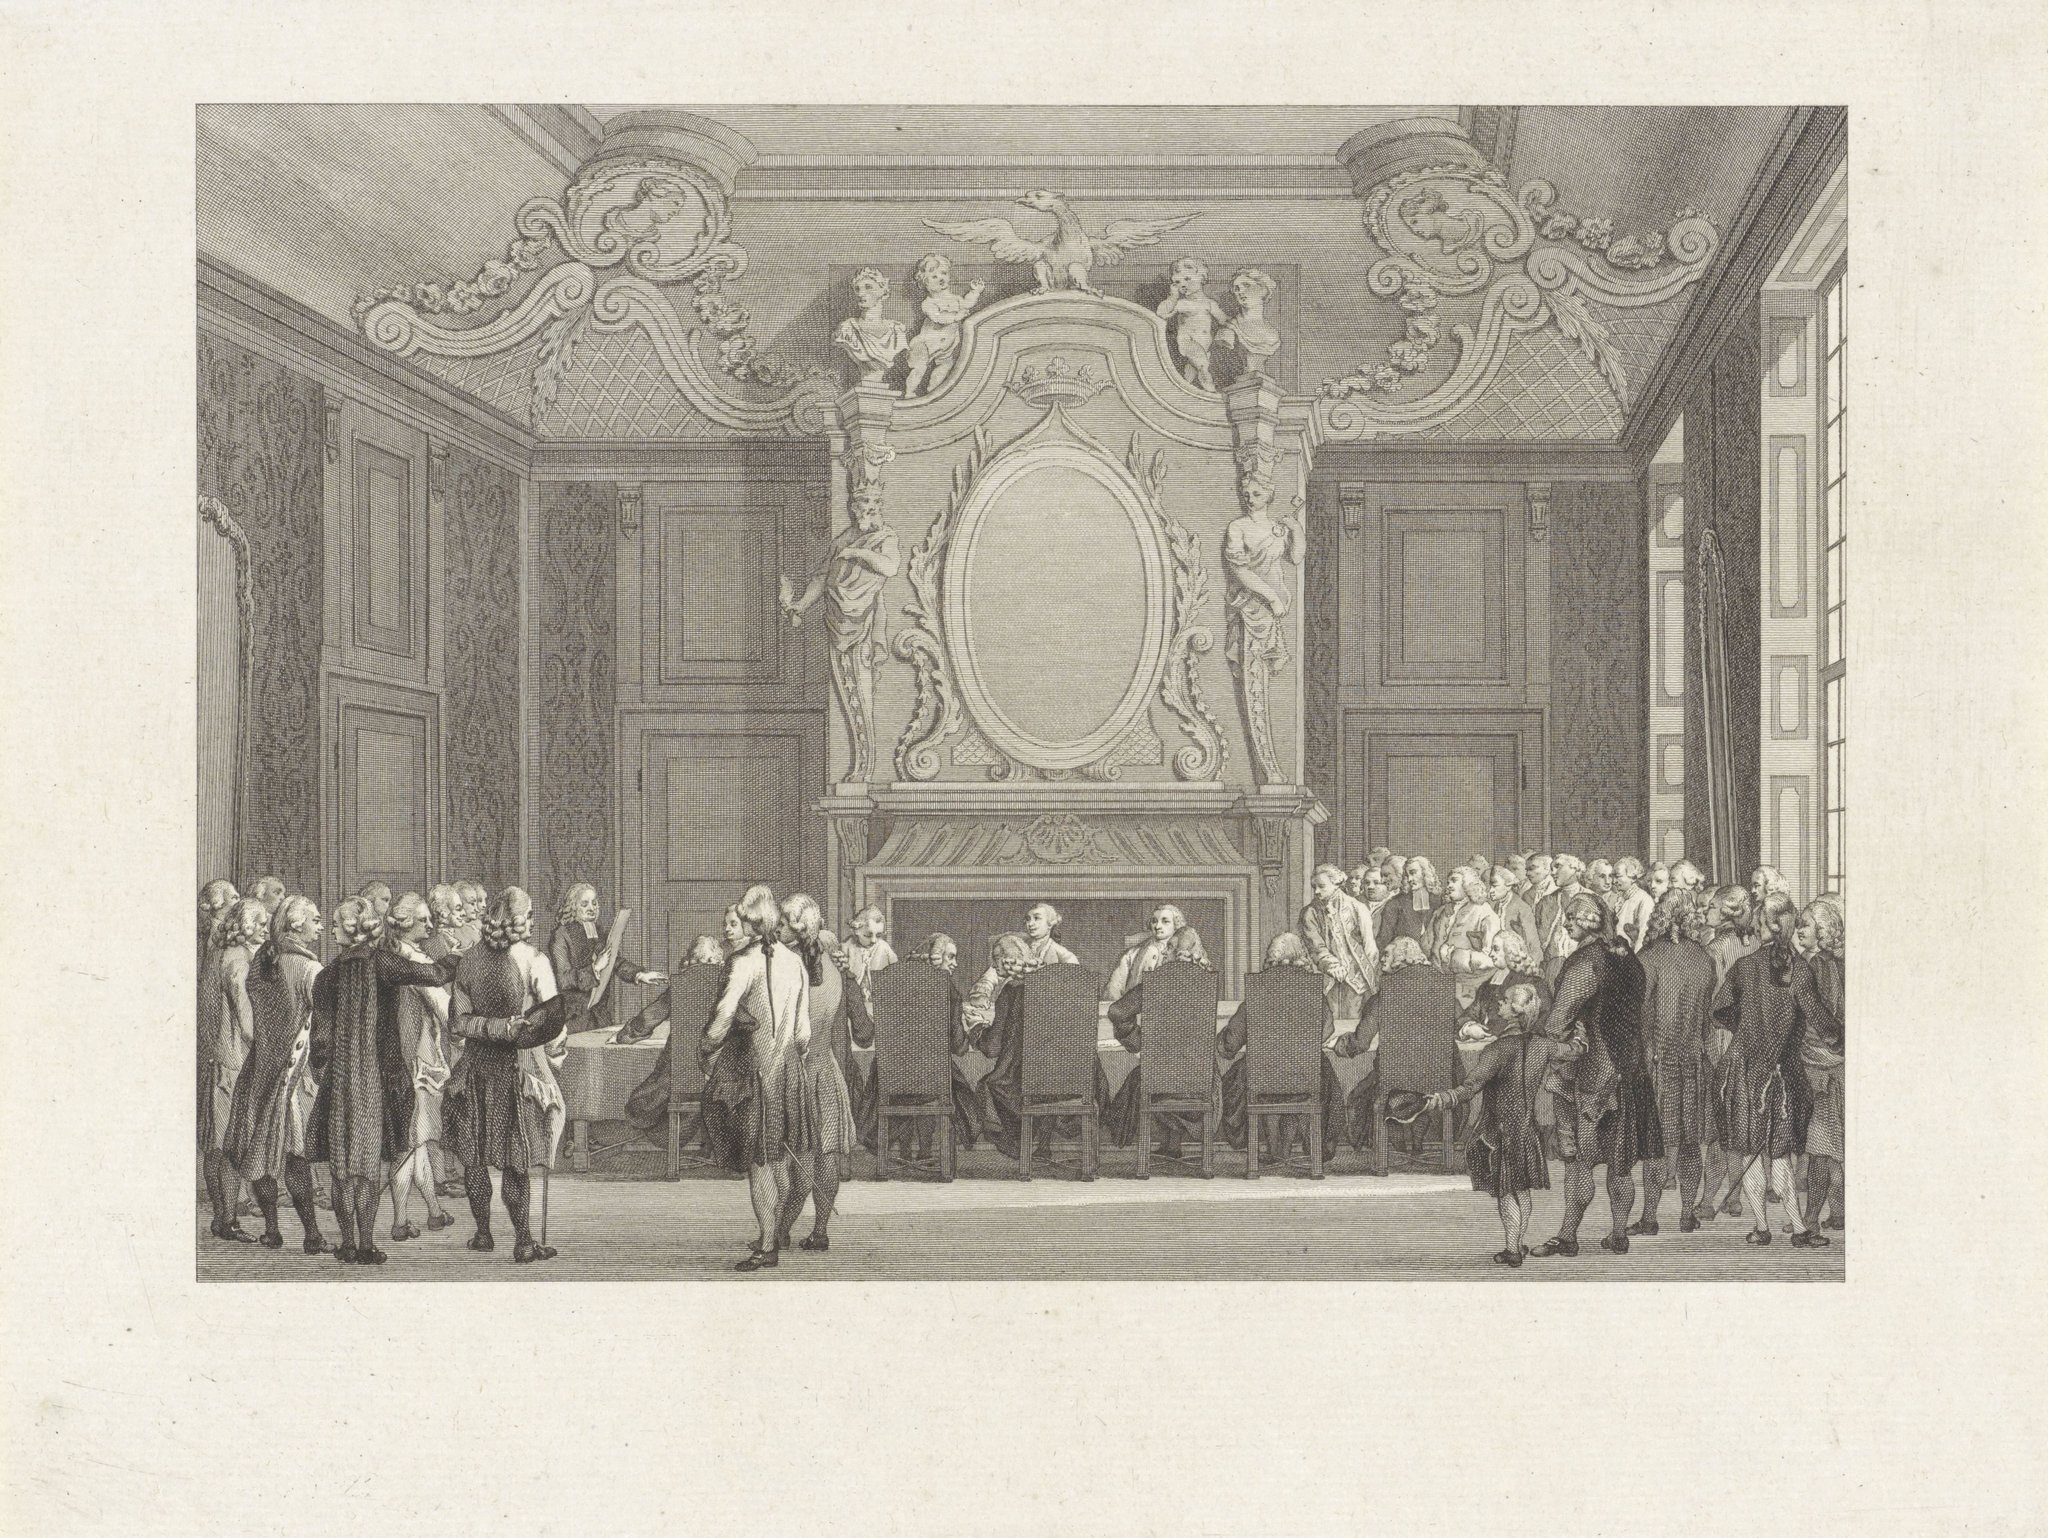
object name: print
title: Openbare voorlezing van enige Psalmen in de nieuwe berijming, 1773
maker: reinier vinkeles (i)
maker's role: draughtsman, print maker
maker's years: 1741-1816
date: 1777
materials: paper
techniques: engraving, etching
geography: amsterdam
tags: reading to somebody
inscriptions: collector's mark: Lugt 240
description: Openbare voorlezing van enige Psalmen in de nieuwe berijming door de Commissie ter Verbetering van de Rijmpsalmen, in de vergaderzaal in het Mauritshuis op 1 oktober 1773. Een groep zittend aan een tafel en meer aanwezigen staand om de tafel. Links staat een lid van de commissie voor te lezen.